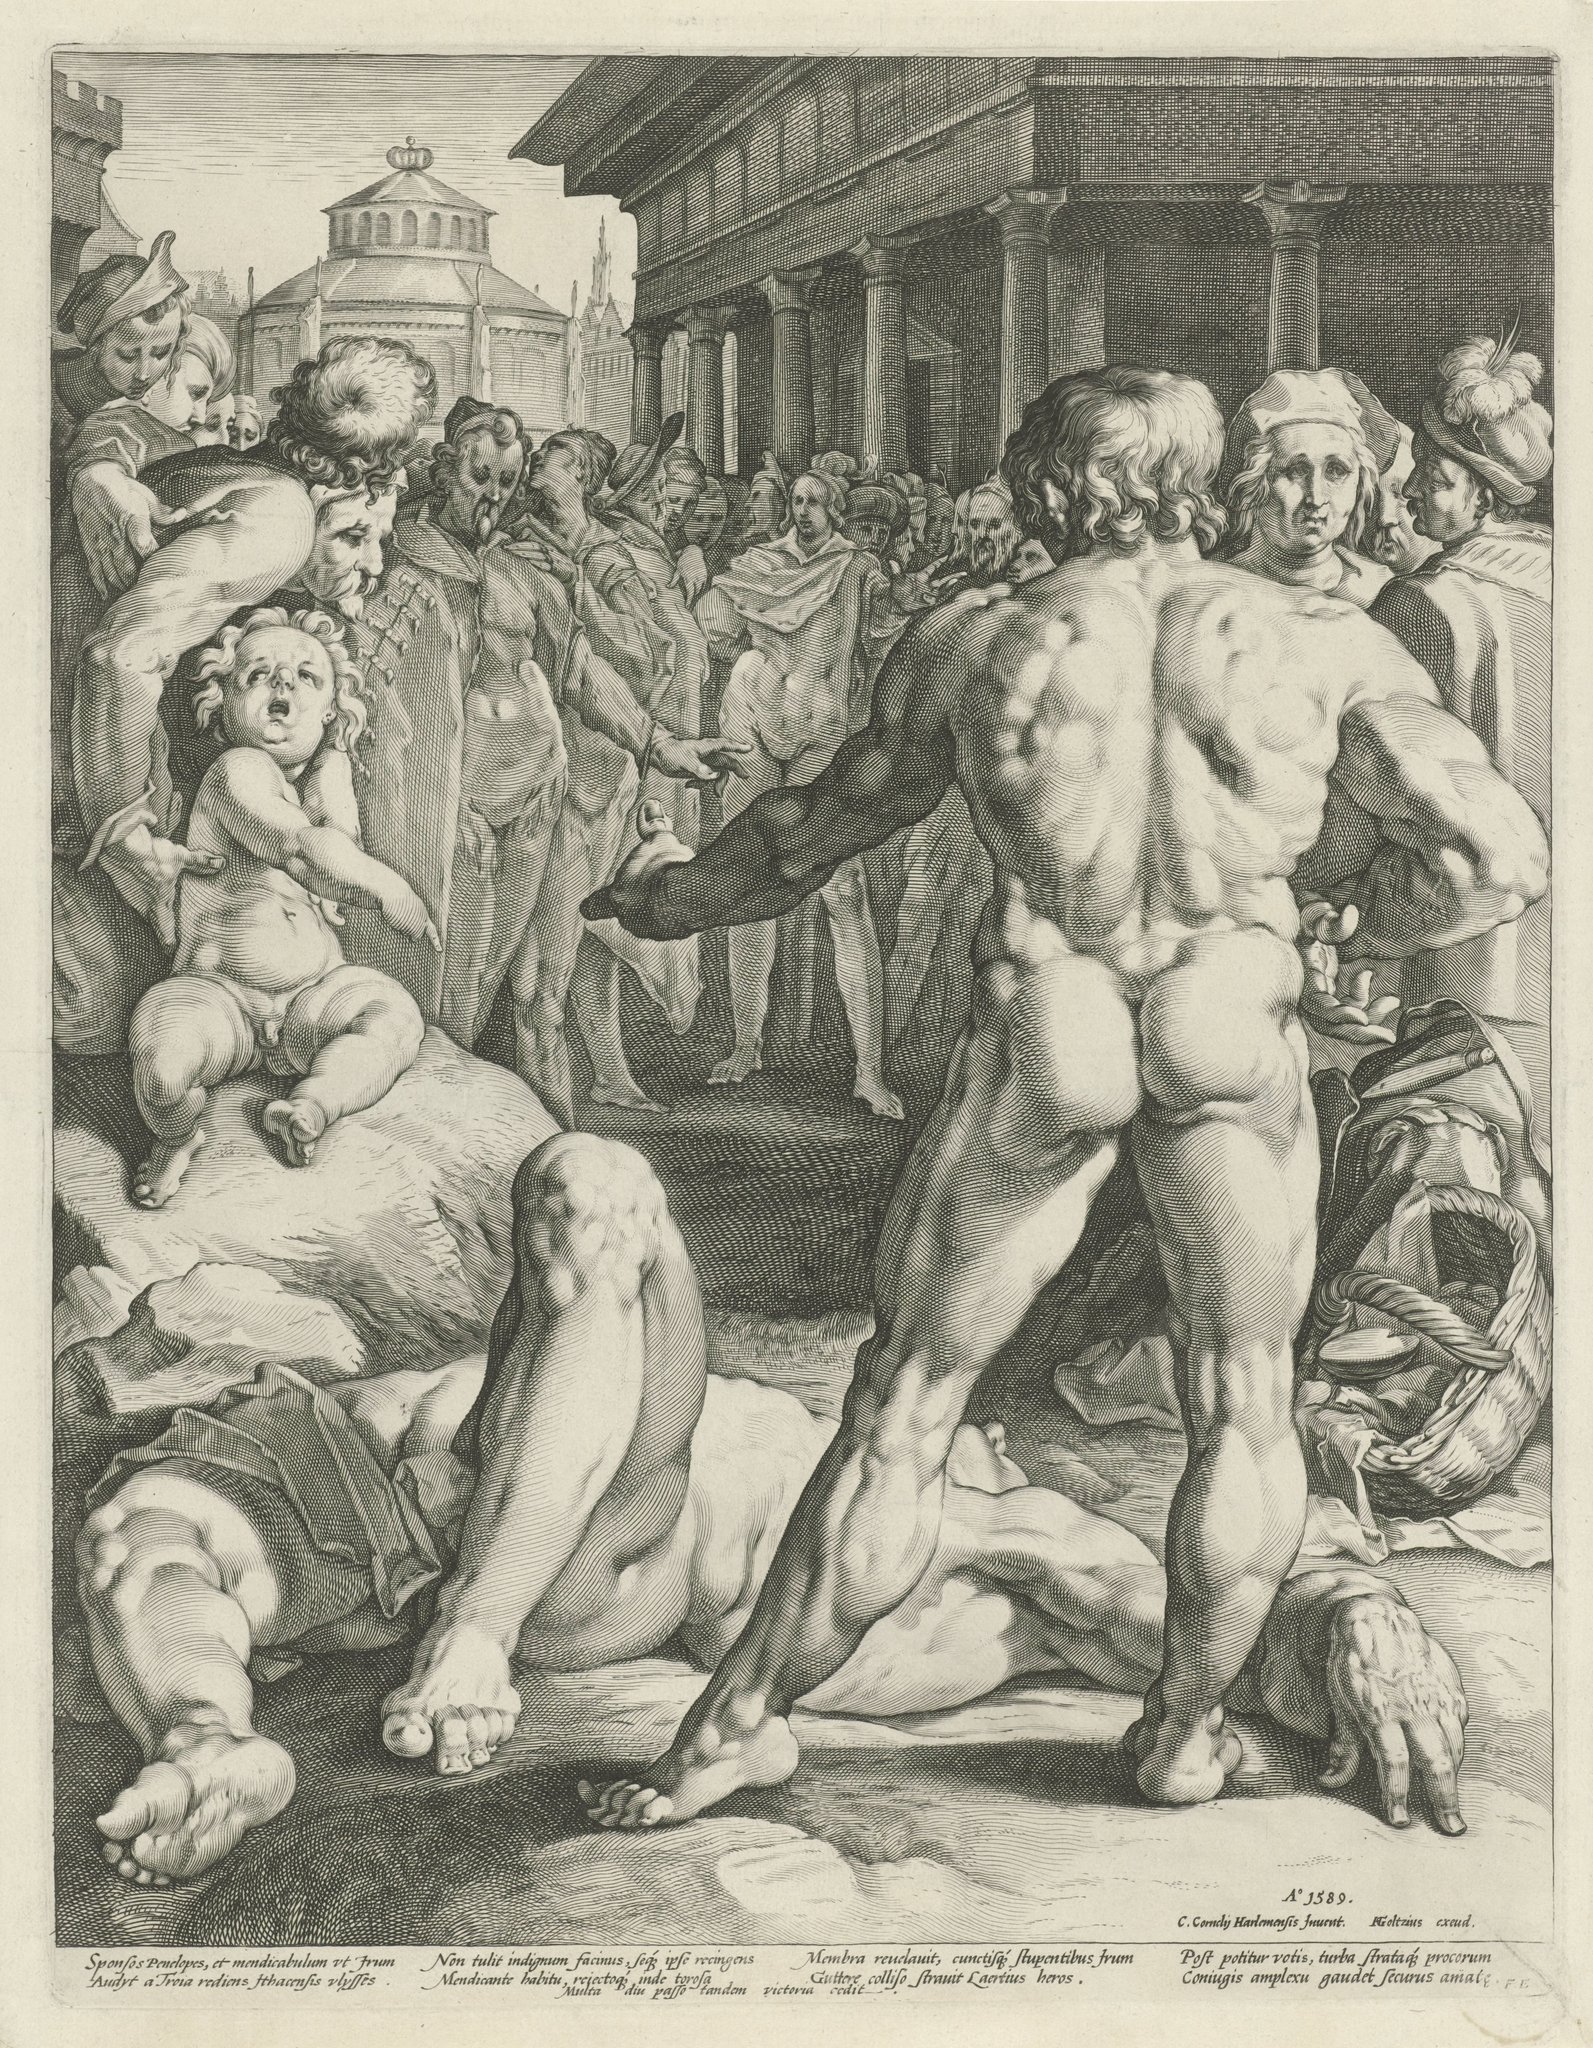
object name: print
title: Gevecht tussen Odysseus en Irus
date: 1589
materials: paper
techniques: engraving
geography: amsterdam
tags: ulysses' fight with irus, the beggar (homer, odyssey xviii)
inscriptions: collector's mark: Lugt 240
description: Bij thuiskomst op Ithaca wordt Odysseus geconfronteerd met de bedelaar Irus. In een gevecht tussen de twee slaat Odysseus Irus neer. Omstanders kijken toe. Onderaan in de marge vier tweeregelige verzen in het Latijn.